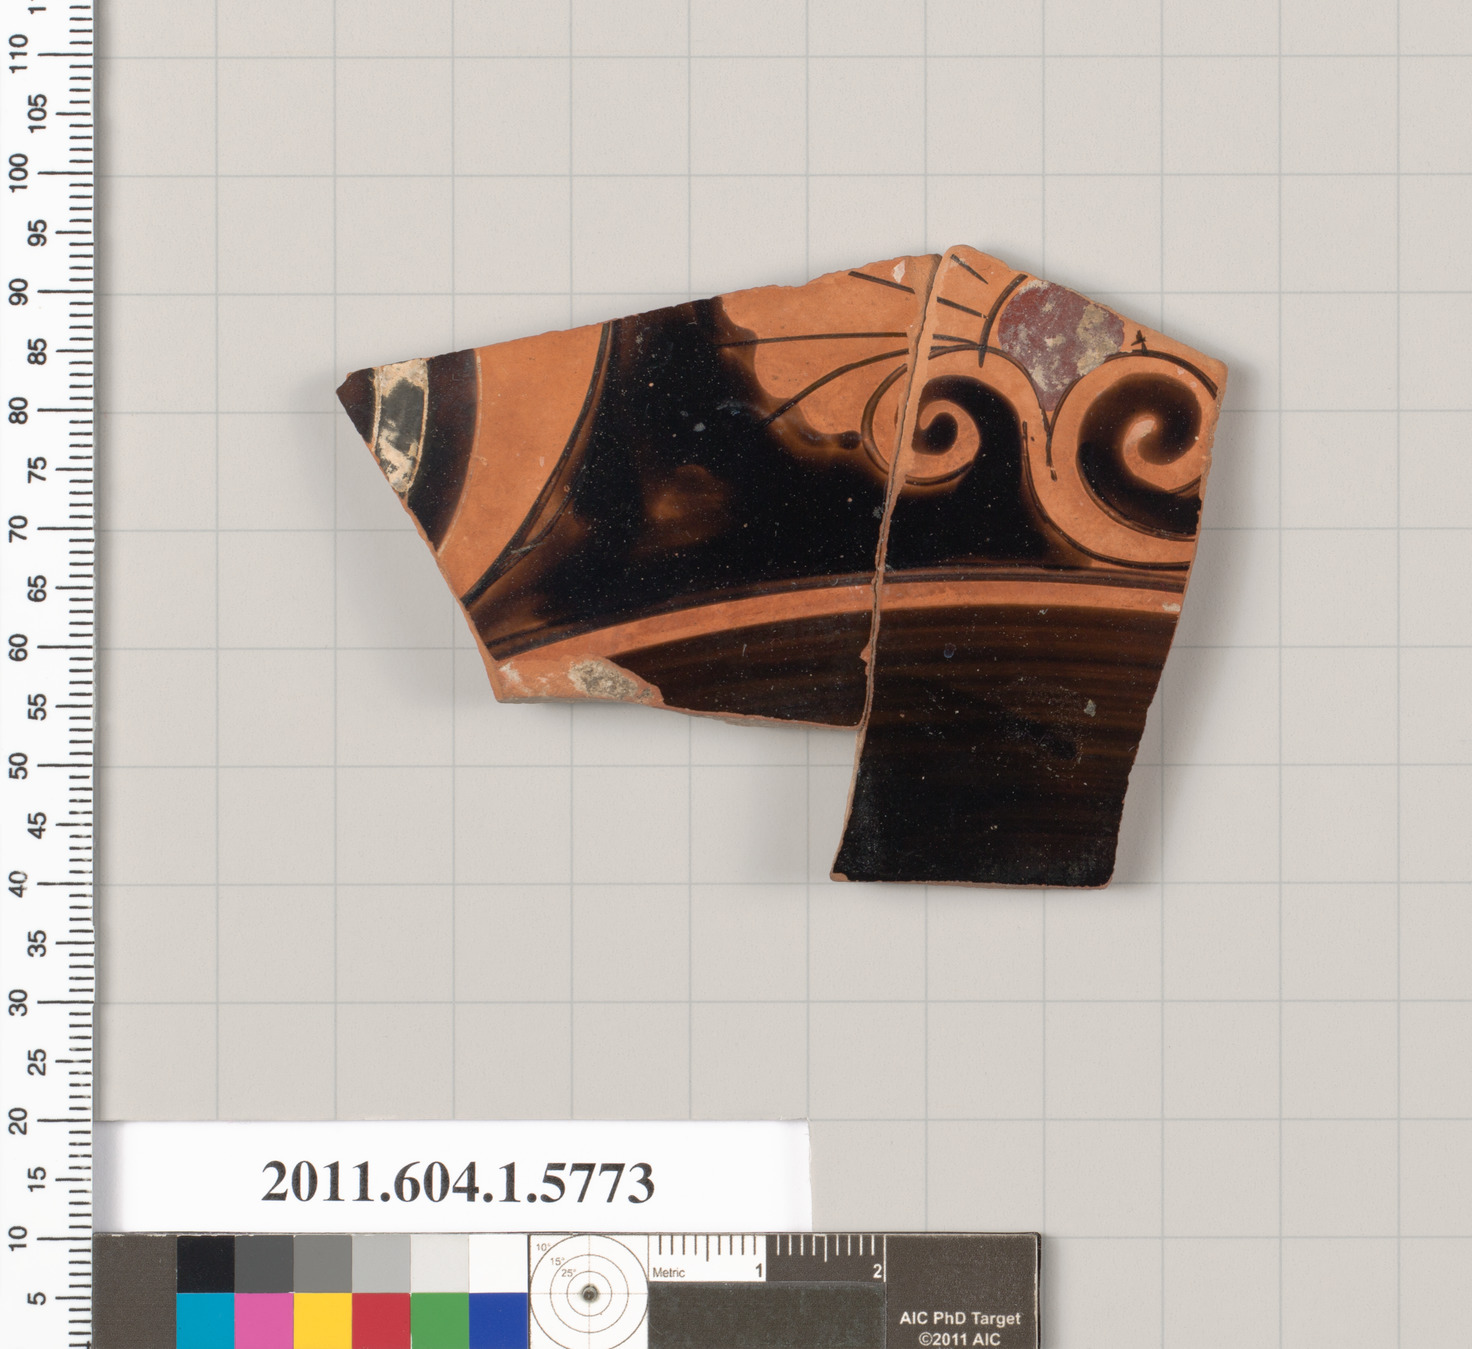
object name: kylix fragment, eye cup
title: Terracotta fragment of a kylix: eye-cup (drinking cup)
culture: greek, attic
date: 525-515 BCE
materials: terracotta